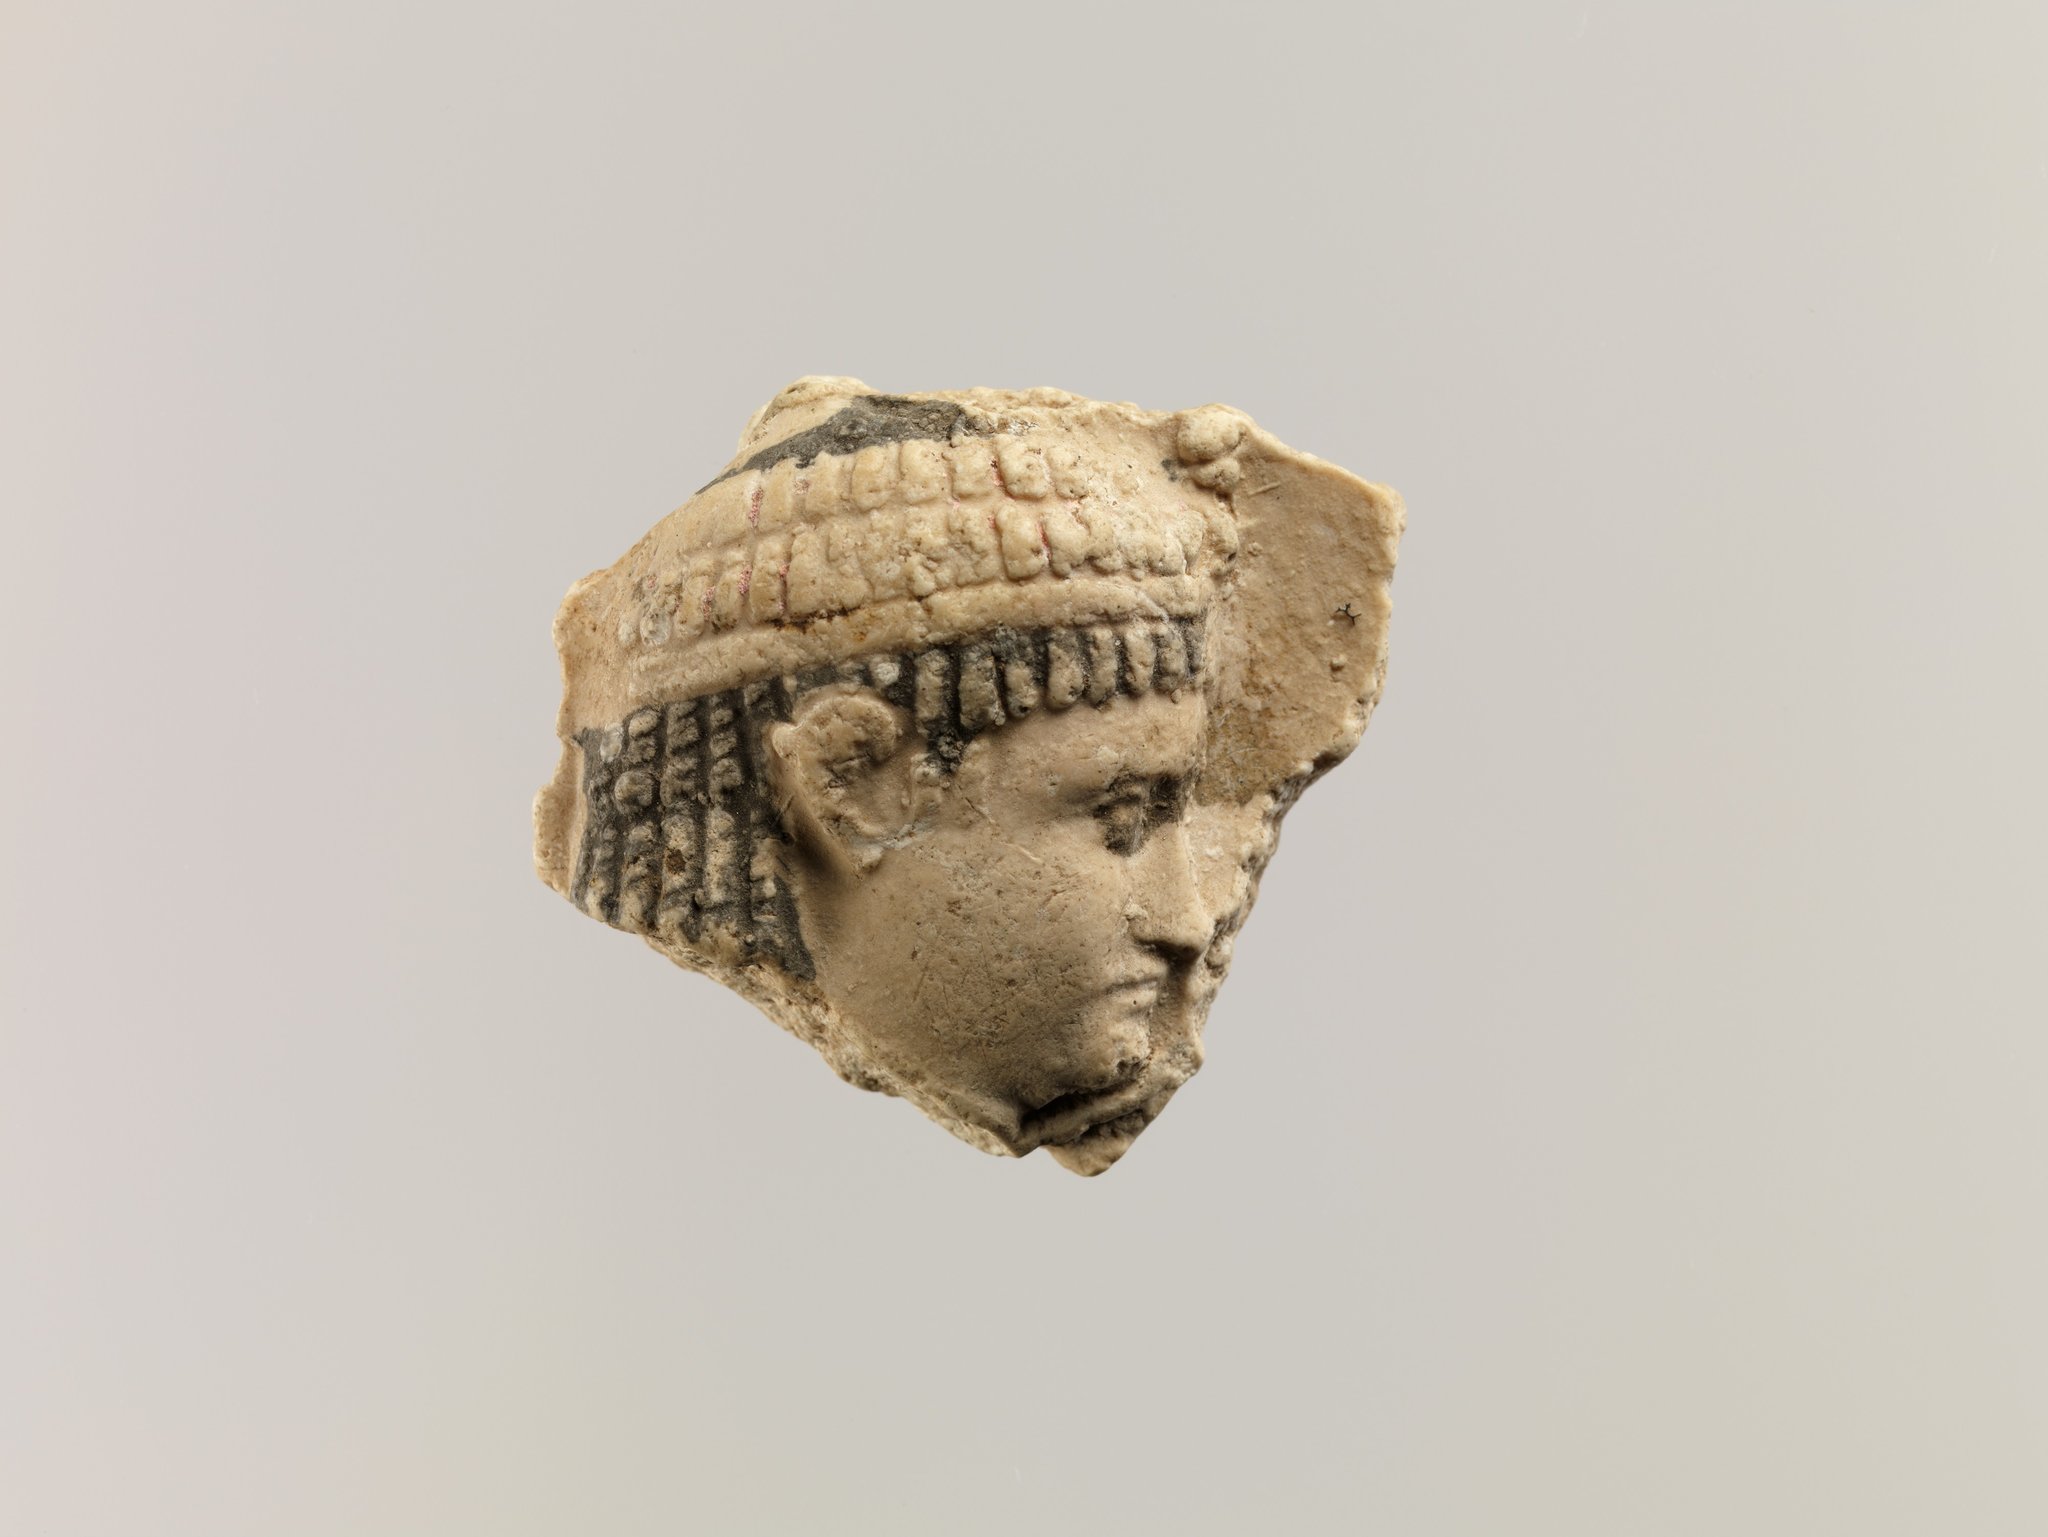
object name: head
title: Female relief head with fillet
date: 332-330 BCE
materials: alabaster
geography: egypt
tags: heads,women